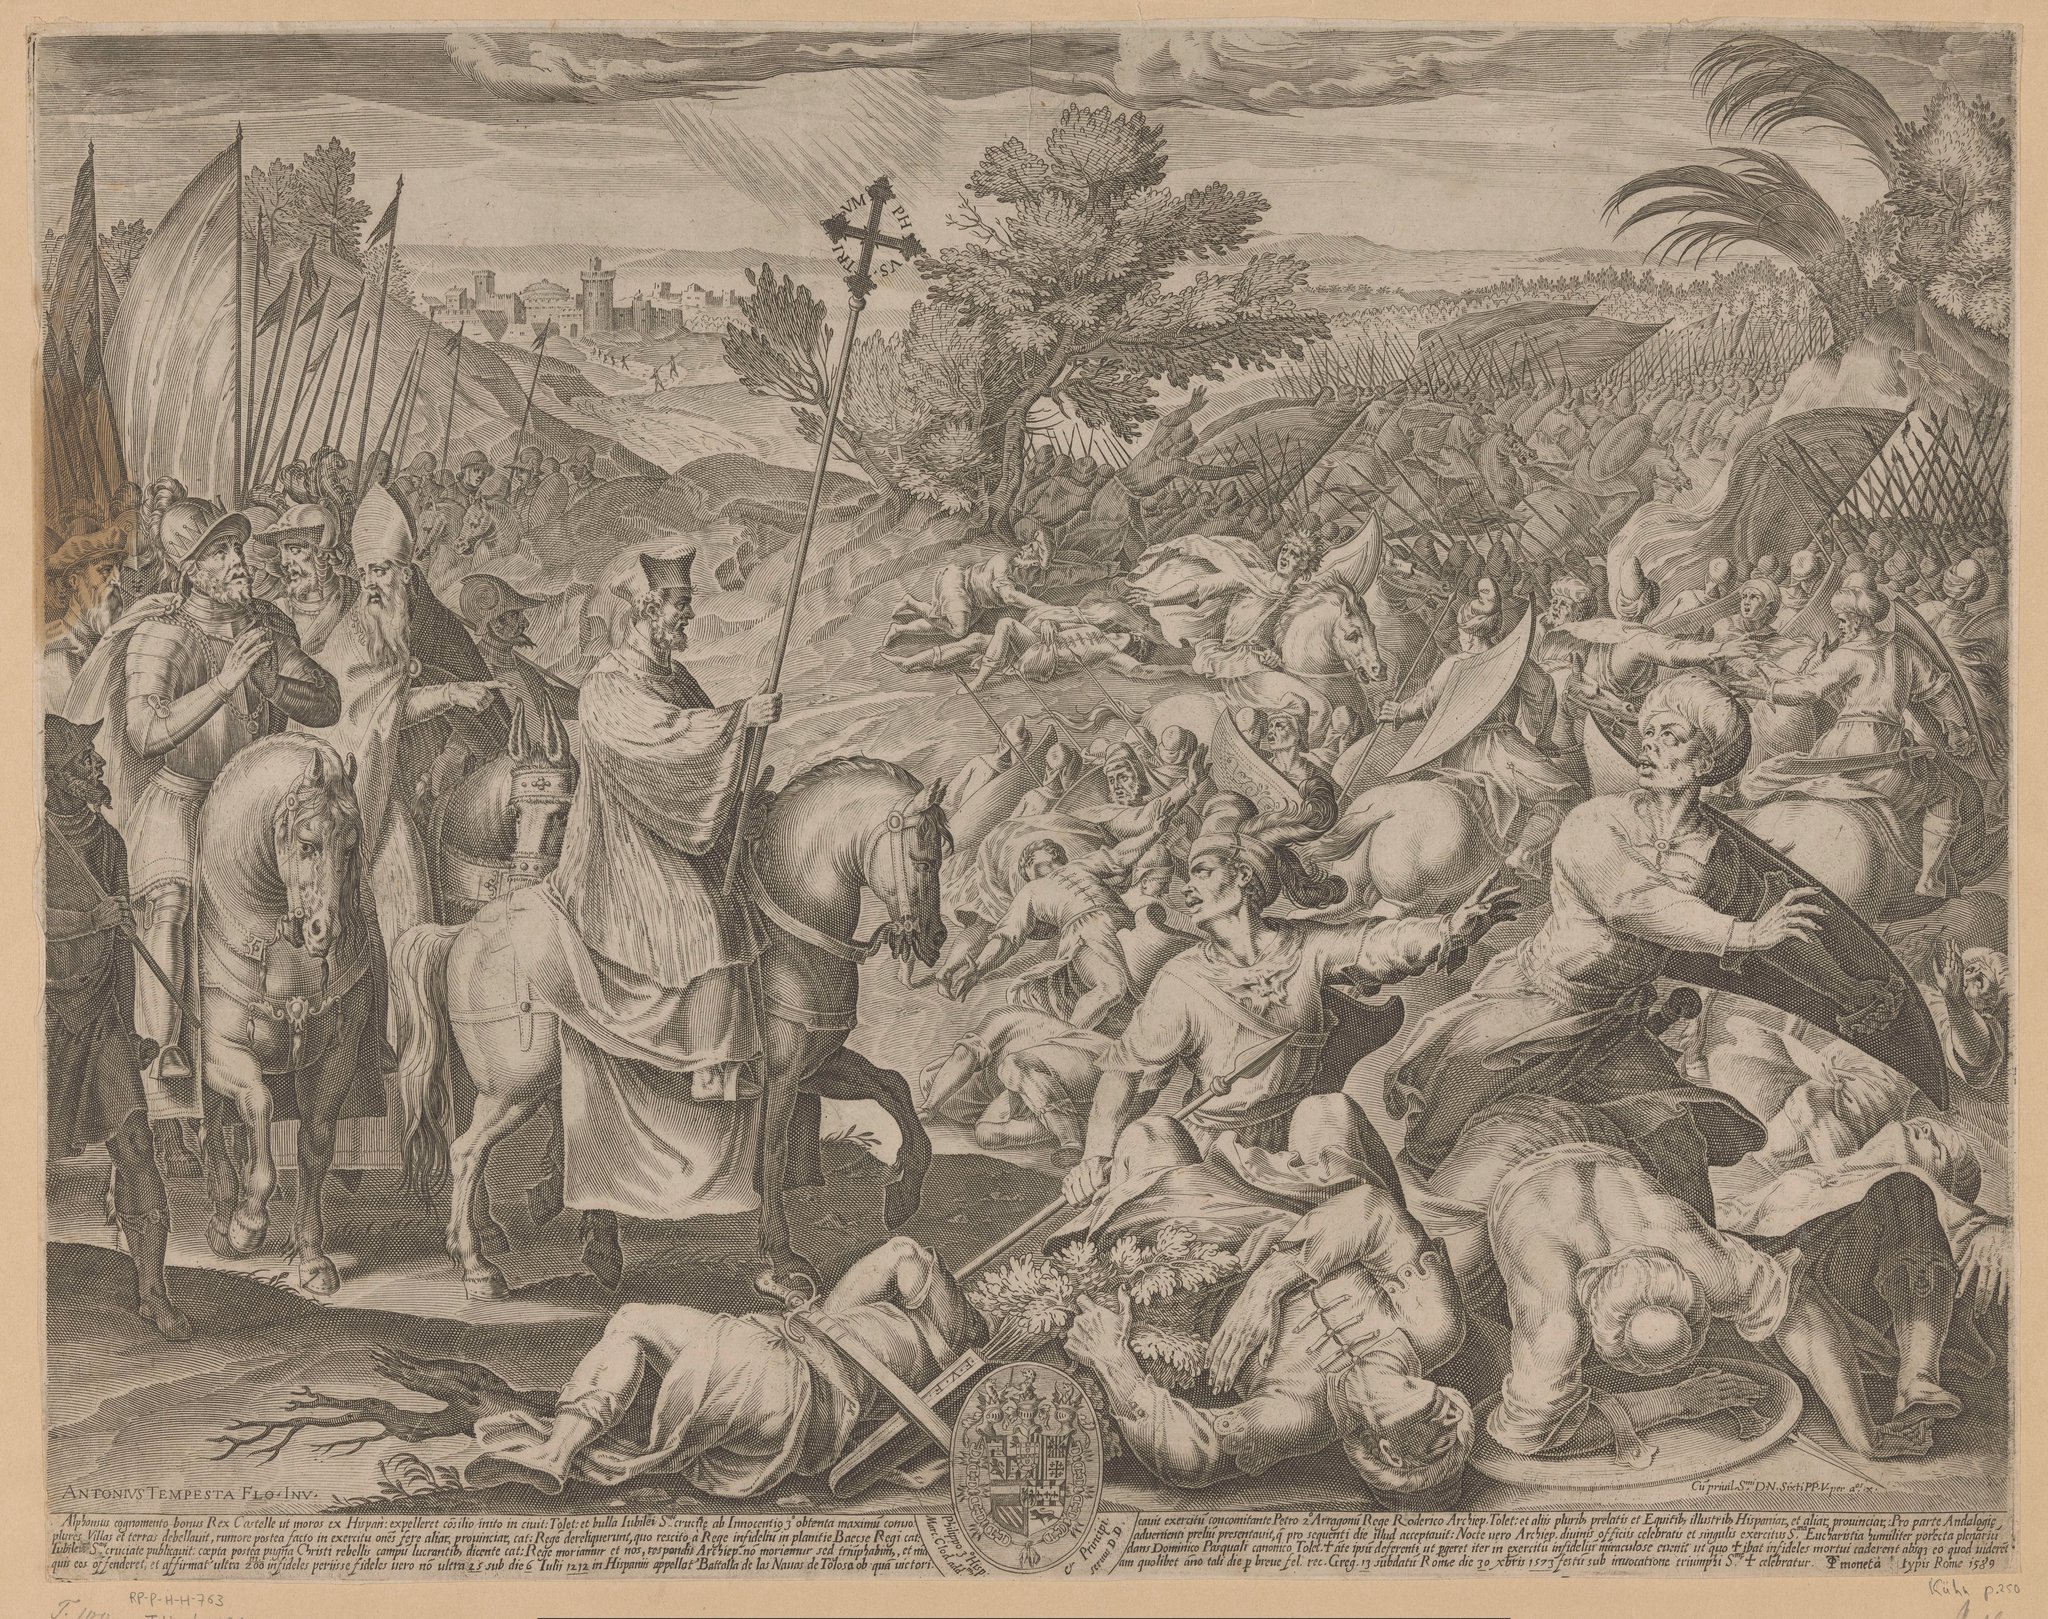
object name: print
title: Slag bij Las Navas de Tolosa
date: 1589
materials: paper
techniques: engraving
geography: rome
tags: battle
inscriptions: collector's mark: Lugt 11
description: Slag bij Las Navas de Tolosa te Spanje waarin de Moorse Almohaden werden verslagen door christelijke legers onder leiding van koning Alfons VIII van Castilië. Links het christelijke leger met voorop kanunnik Domenico Pasquali met een triomfkruis, gevolgd door Alfons VIII en Rodrigo Ximénez, aartsbisschop van Toledo. Rechts de Almohaden waarvan sommigen zijn gesneuveld en anderen zich terugtrekken. Opdracht, wapenschild en vierregelige Latijnse tekst in ondermarge.